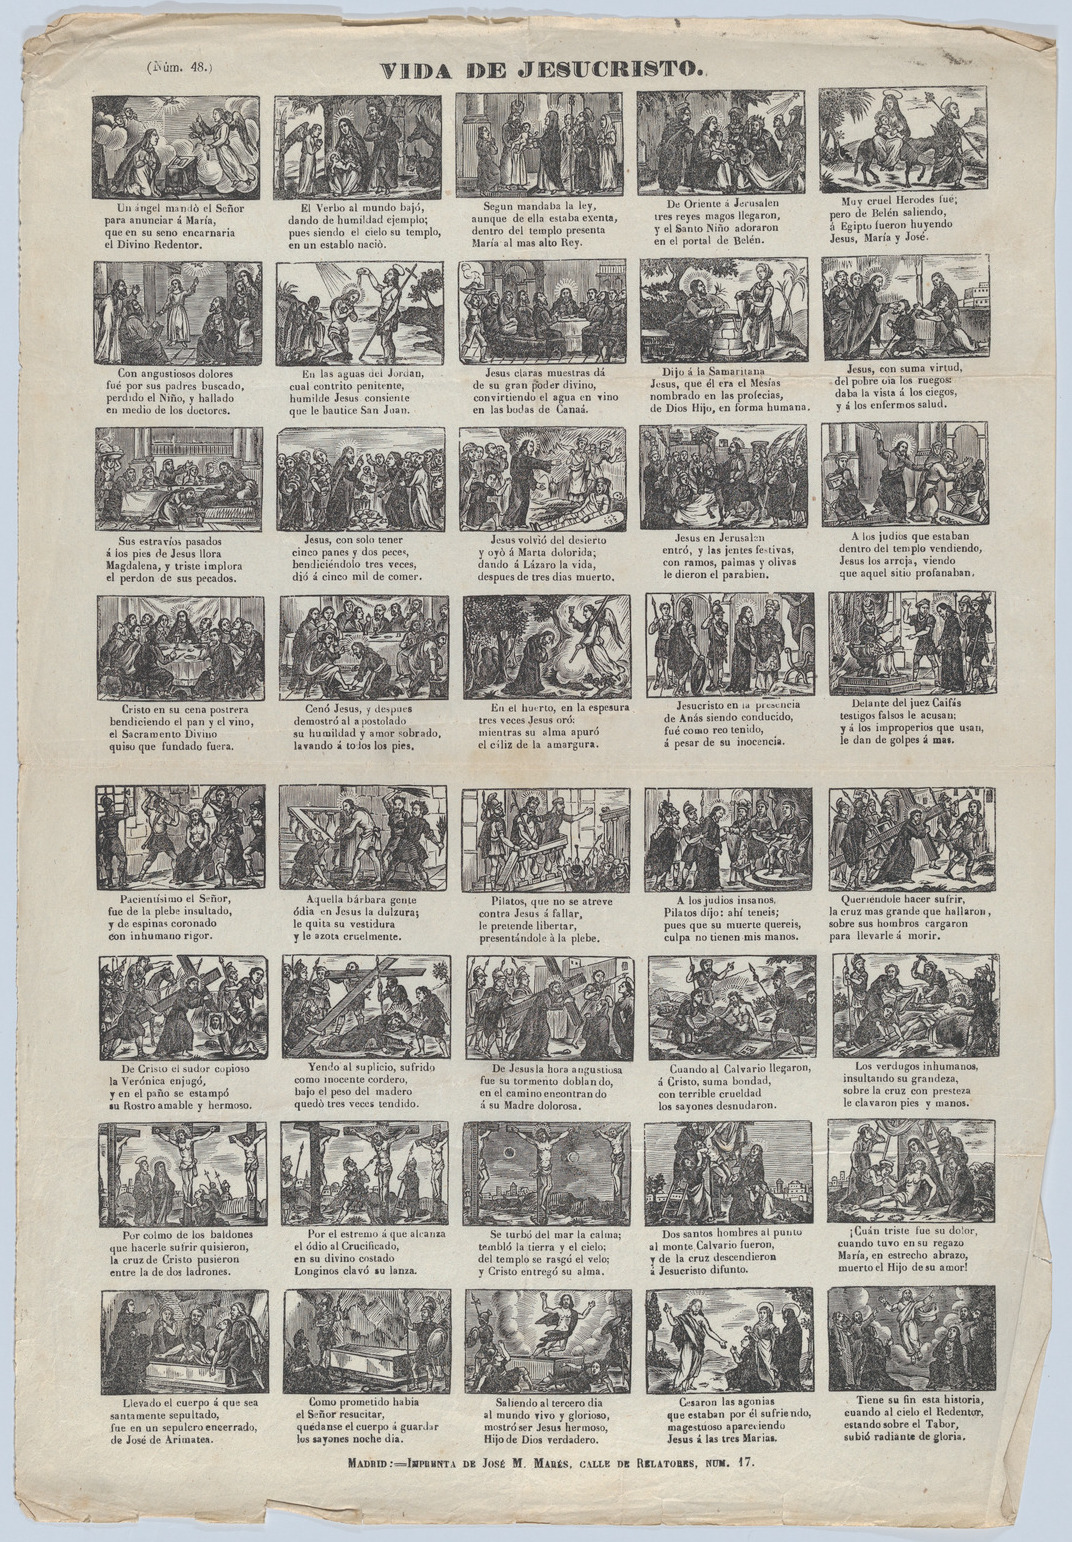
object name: print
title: Broadside with 48 scenes illustrating the life of Christ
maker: josé maría marés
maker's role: publisher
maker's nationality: spanish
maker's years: 1850-1870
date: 1860-1870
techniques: engraving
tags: christ,baptism of christ,crucifixion,lamentation,last supper